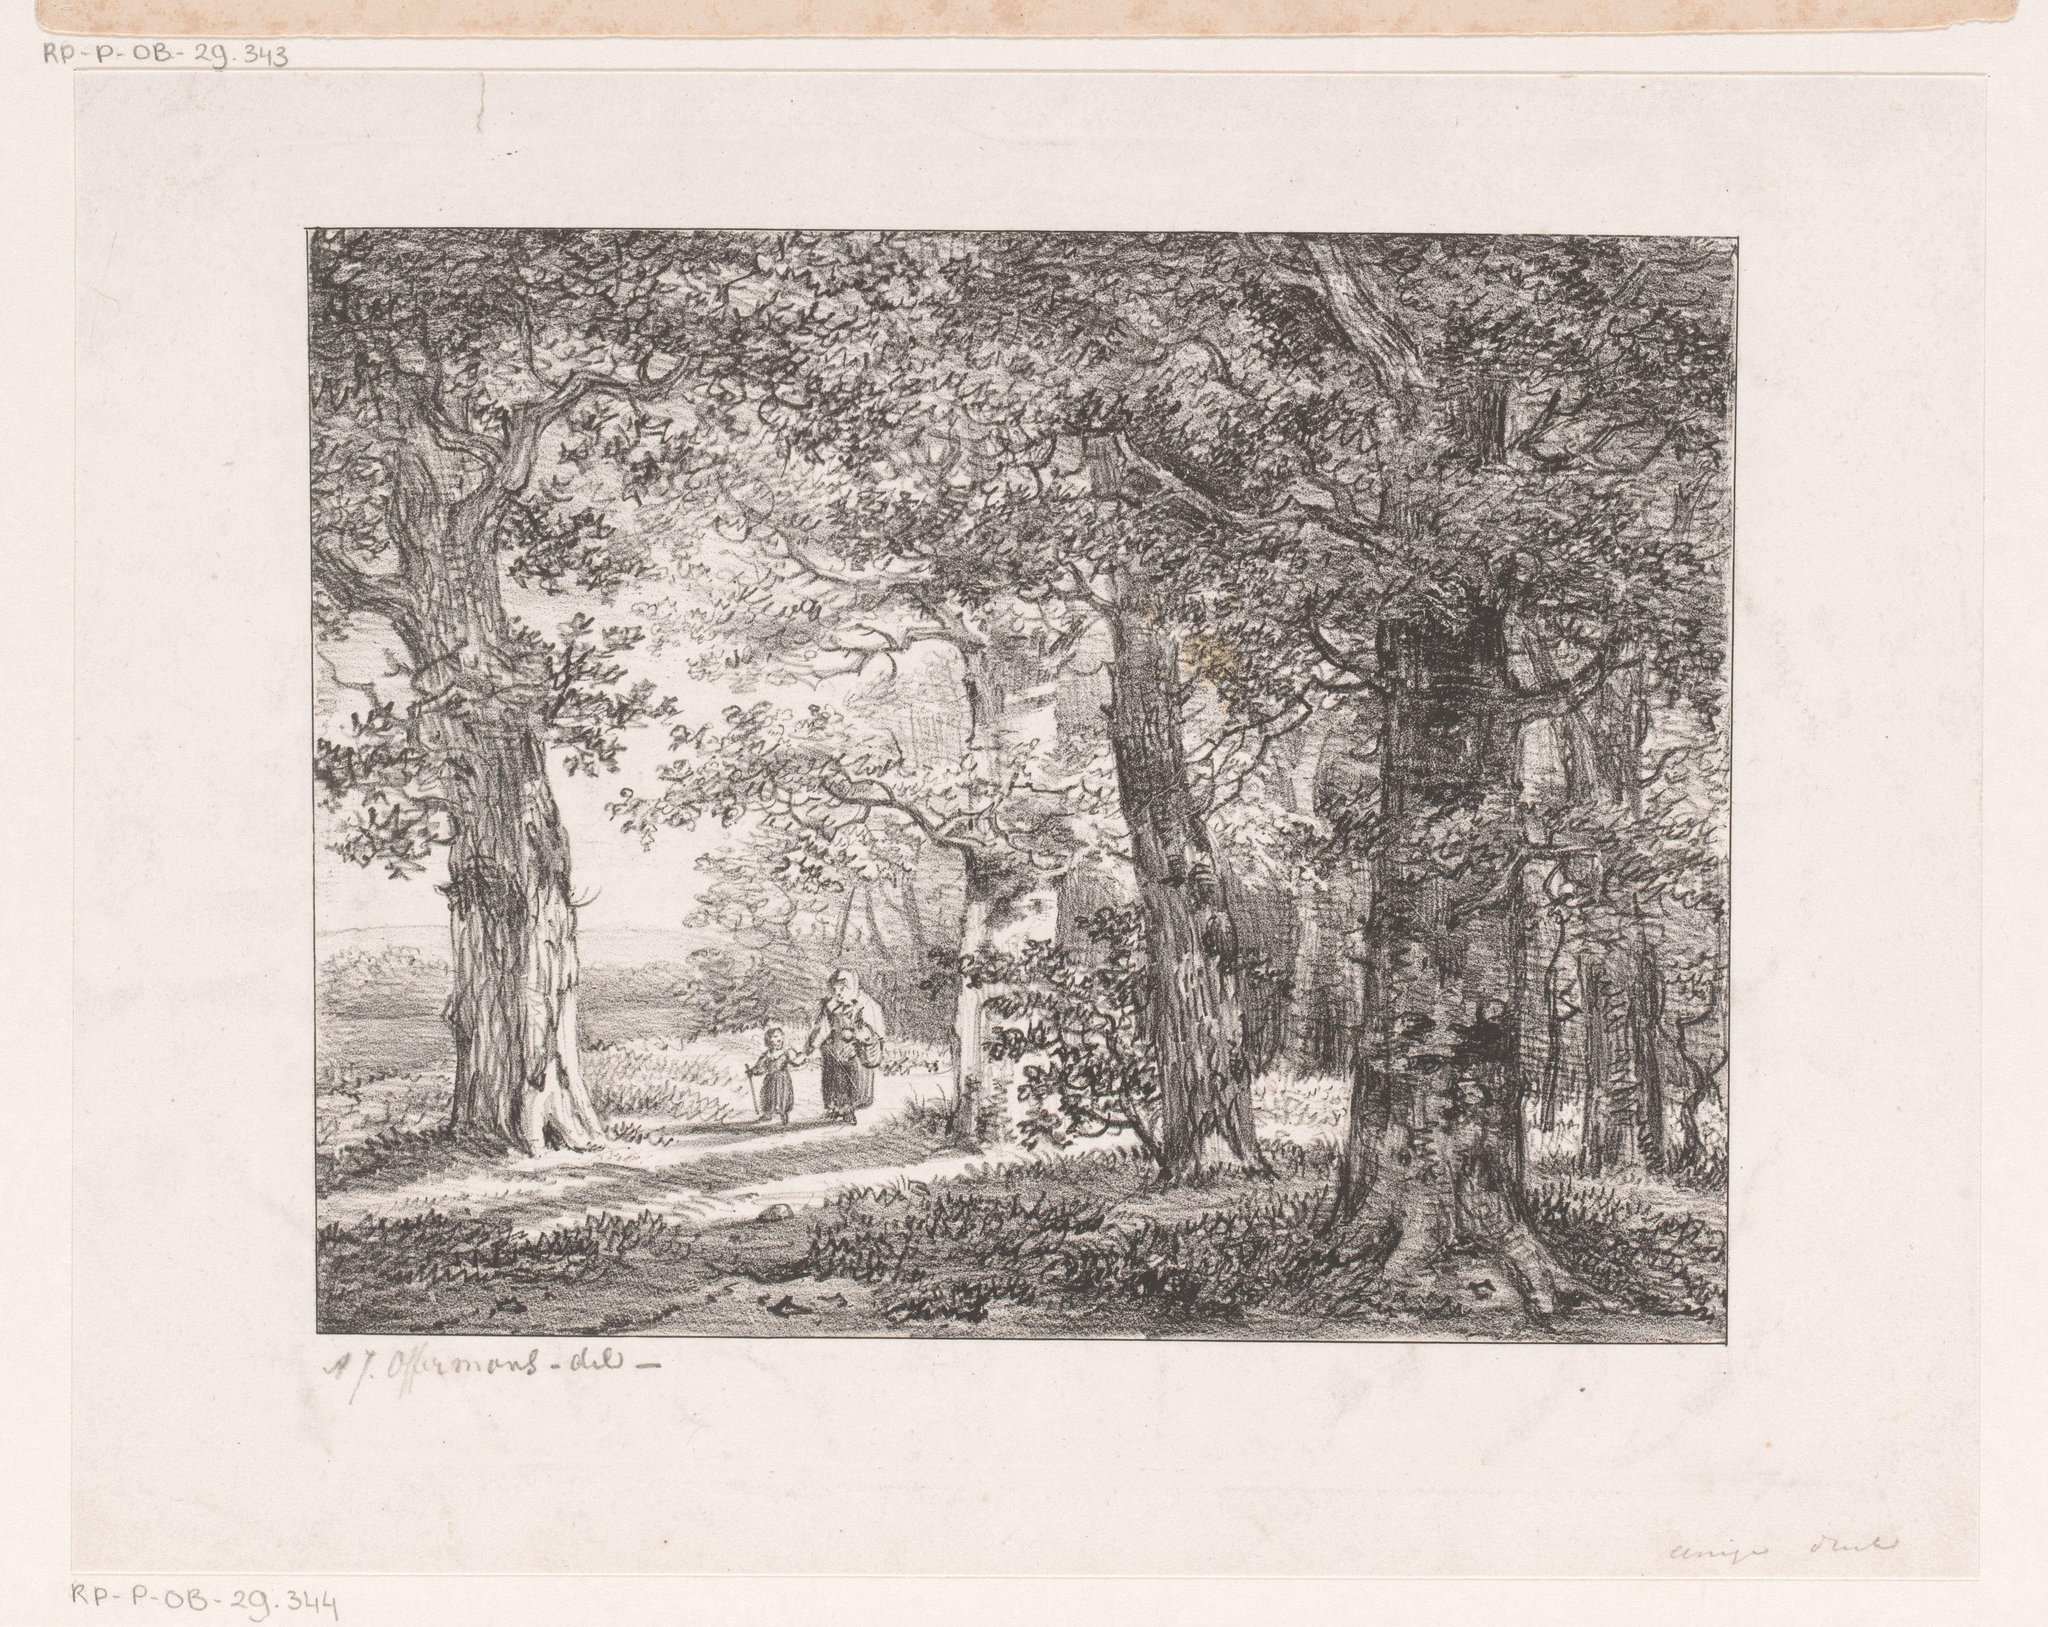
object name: print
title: Vrouw en kind in bos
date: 1809-1872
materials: paper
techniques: lithograph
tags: forest, wood, mother and child(ren), woman and child(ren) (family group)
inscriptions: collector's mark: Lugt 2228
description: Een vrouw met mand loopt met een kind met een stok op een pad in een bos.